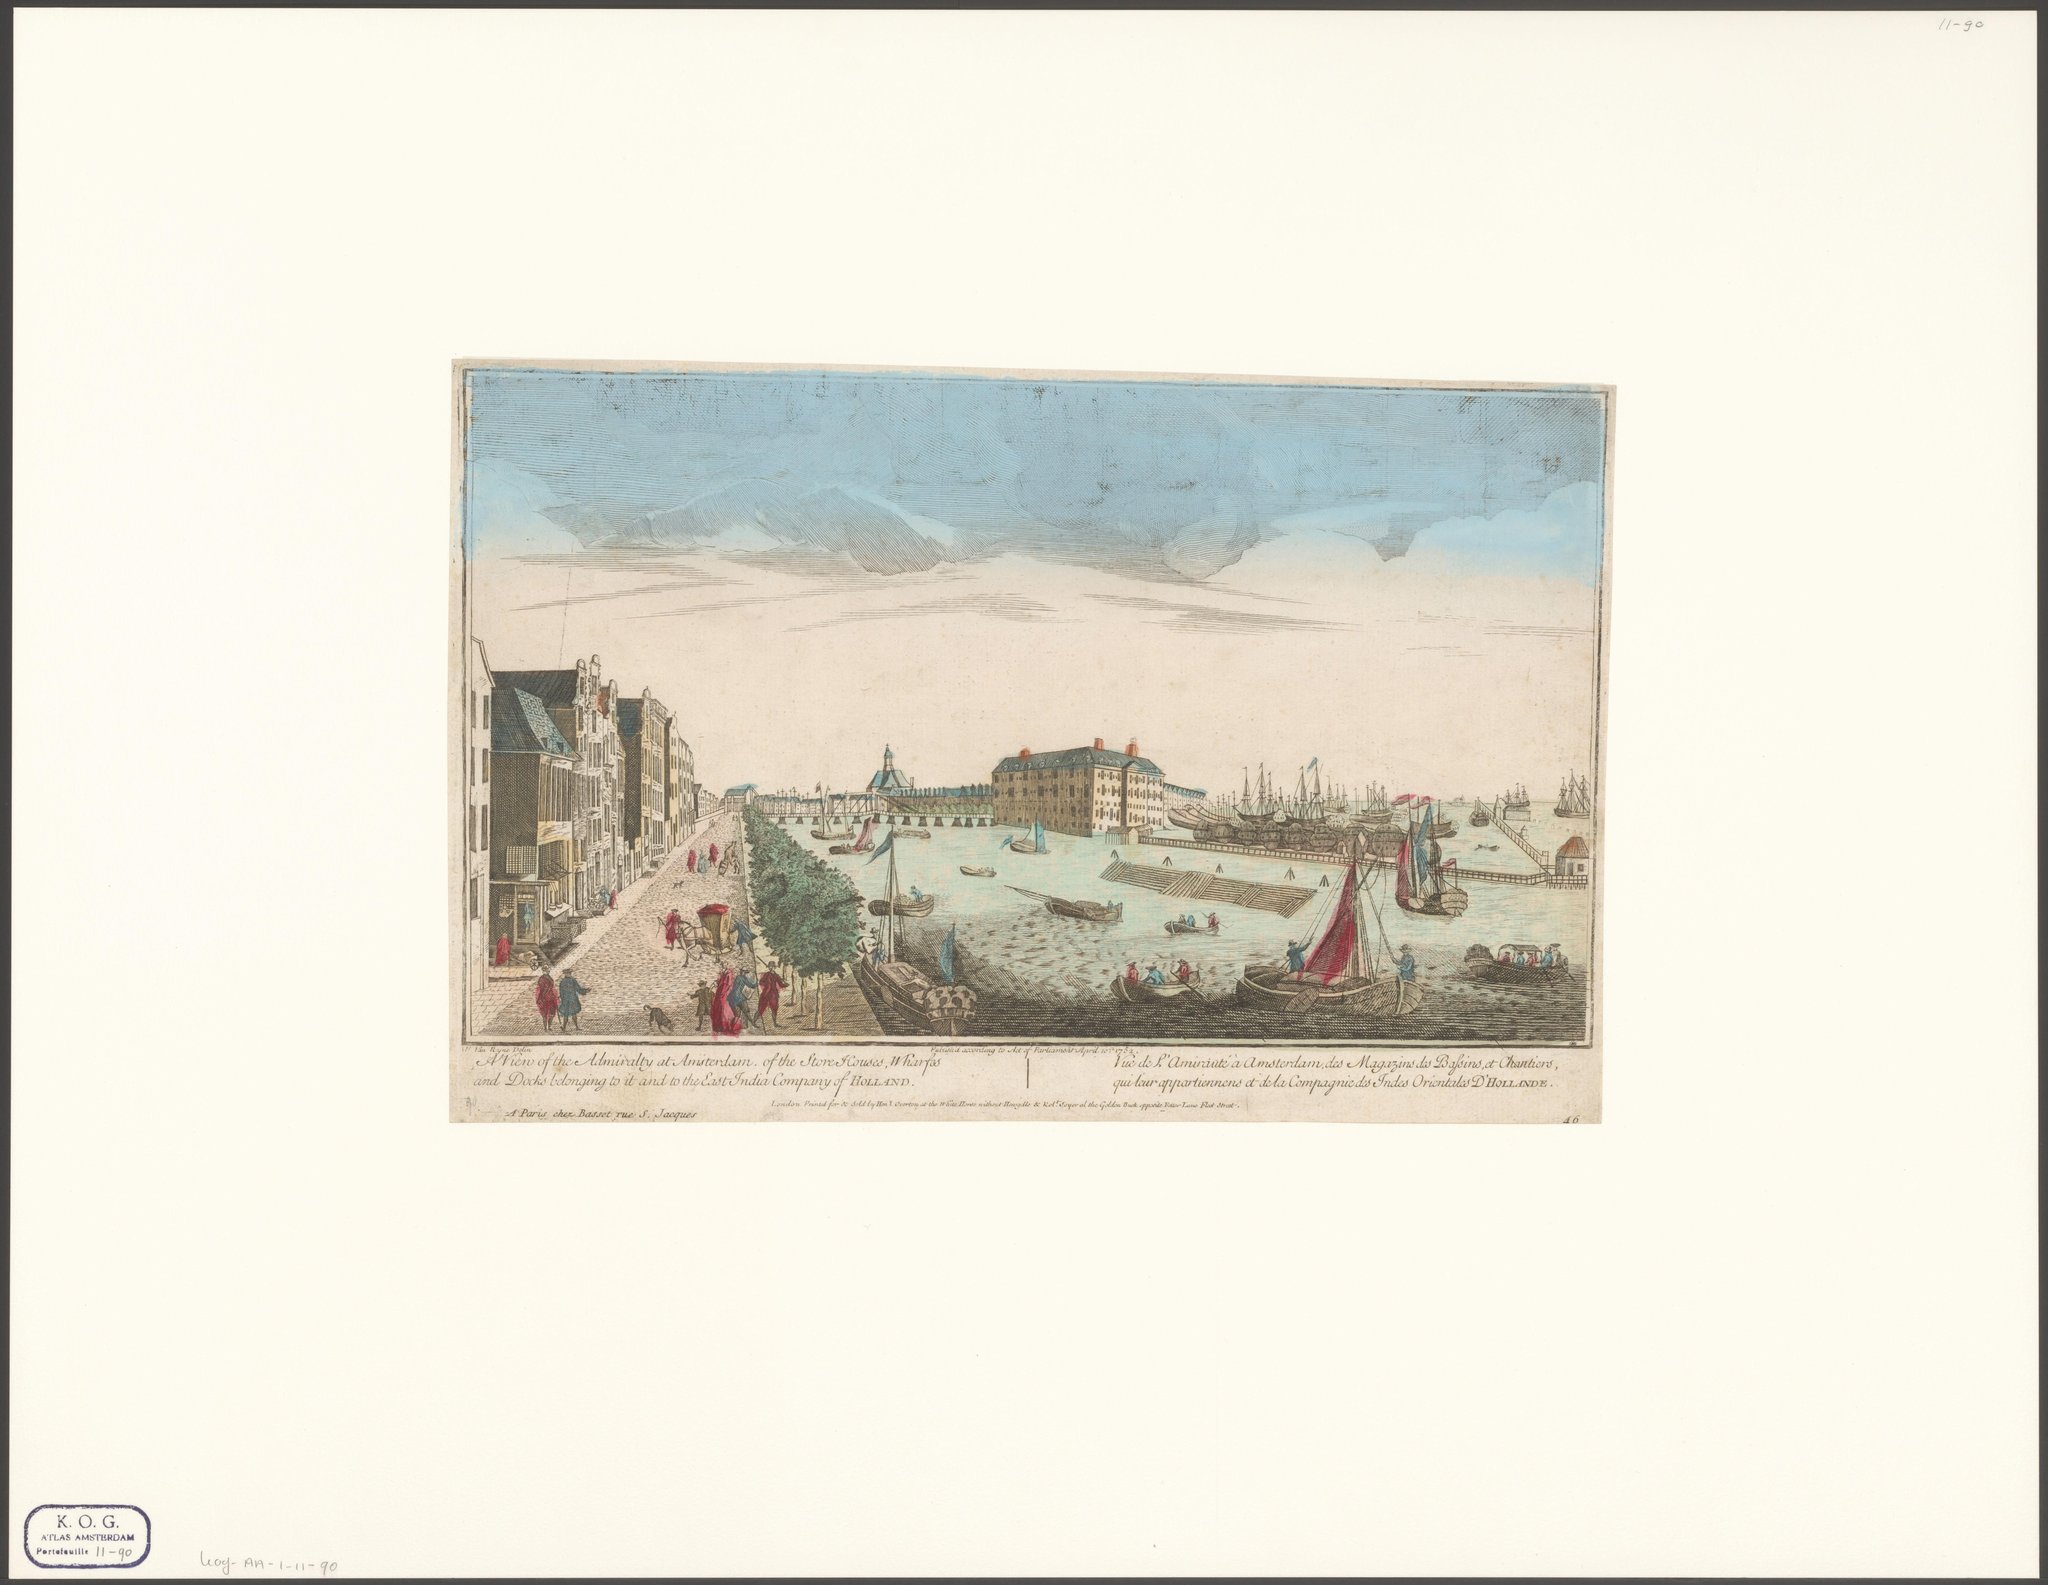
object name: print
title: A view of the Admiralty at Amsterdam, of the store houses, wharfes and docks, belonging to it and to the East India Company of Holland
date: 1752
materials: paper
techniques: engraving, etching, hand coloring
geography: paris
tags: sailing-ship, sailing-boat, city-view in general; 'veduta', river, boat propelled by man or animal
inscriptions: collector's mark: ‘11.90’ Lugt 1641b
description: Onderwerpsrubriek binnen de Atlas Amsterdam: Prinsengracht, Korte Prinsengracht, Prins Hendrikkade. Zie ook Portefeuille 1: gezichten van het IJ op de stad. Genummerd rechtsonder: 46.